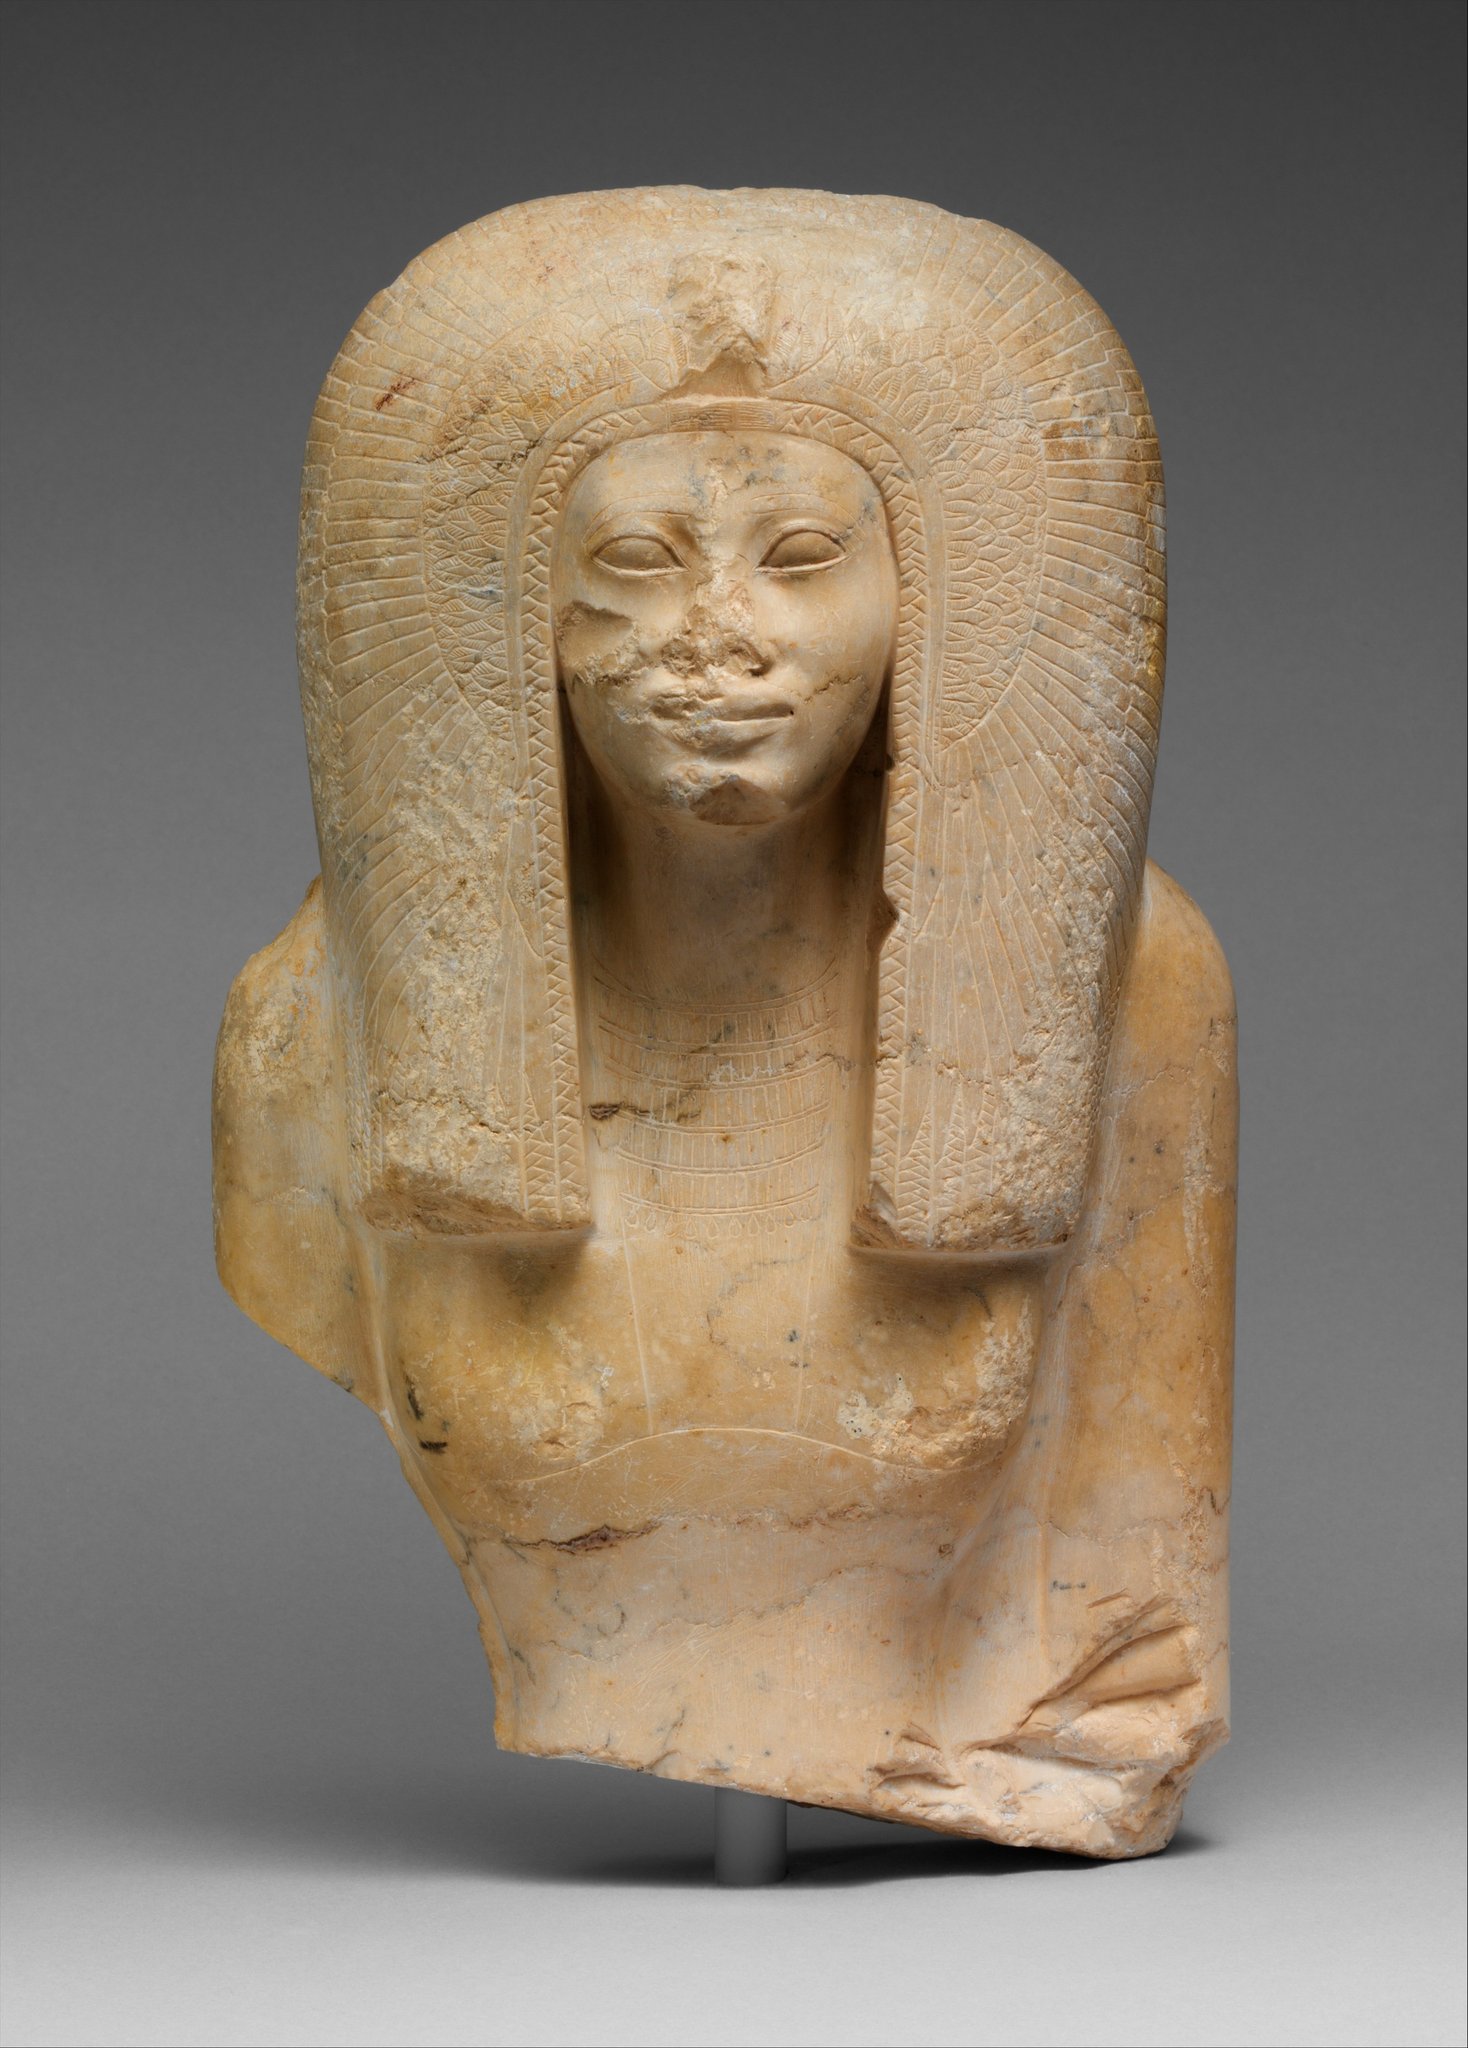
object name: bust, queen, seated, vulture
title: Upper Part of the Seated Statue of a Queen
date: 1580-1550 BCE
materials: limestone, paint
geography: egypt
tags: queens